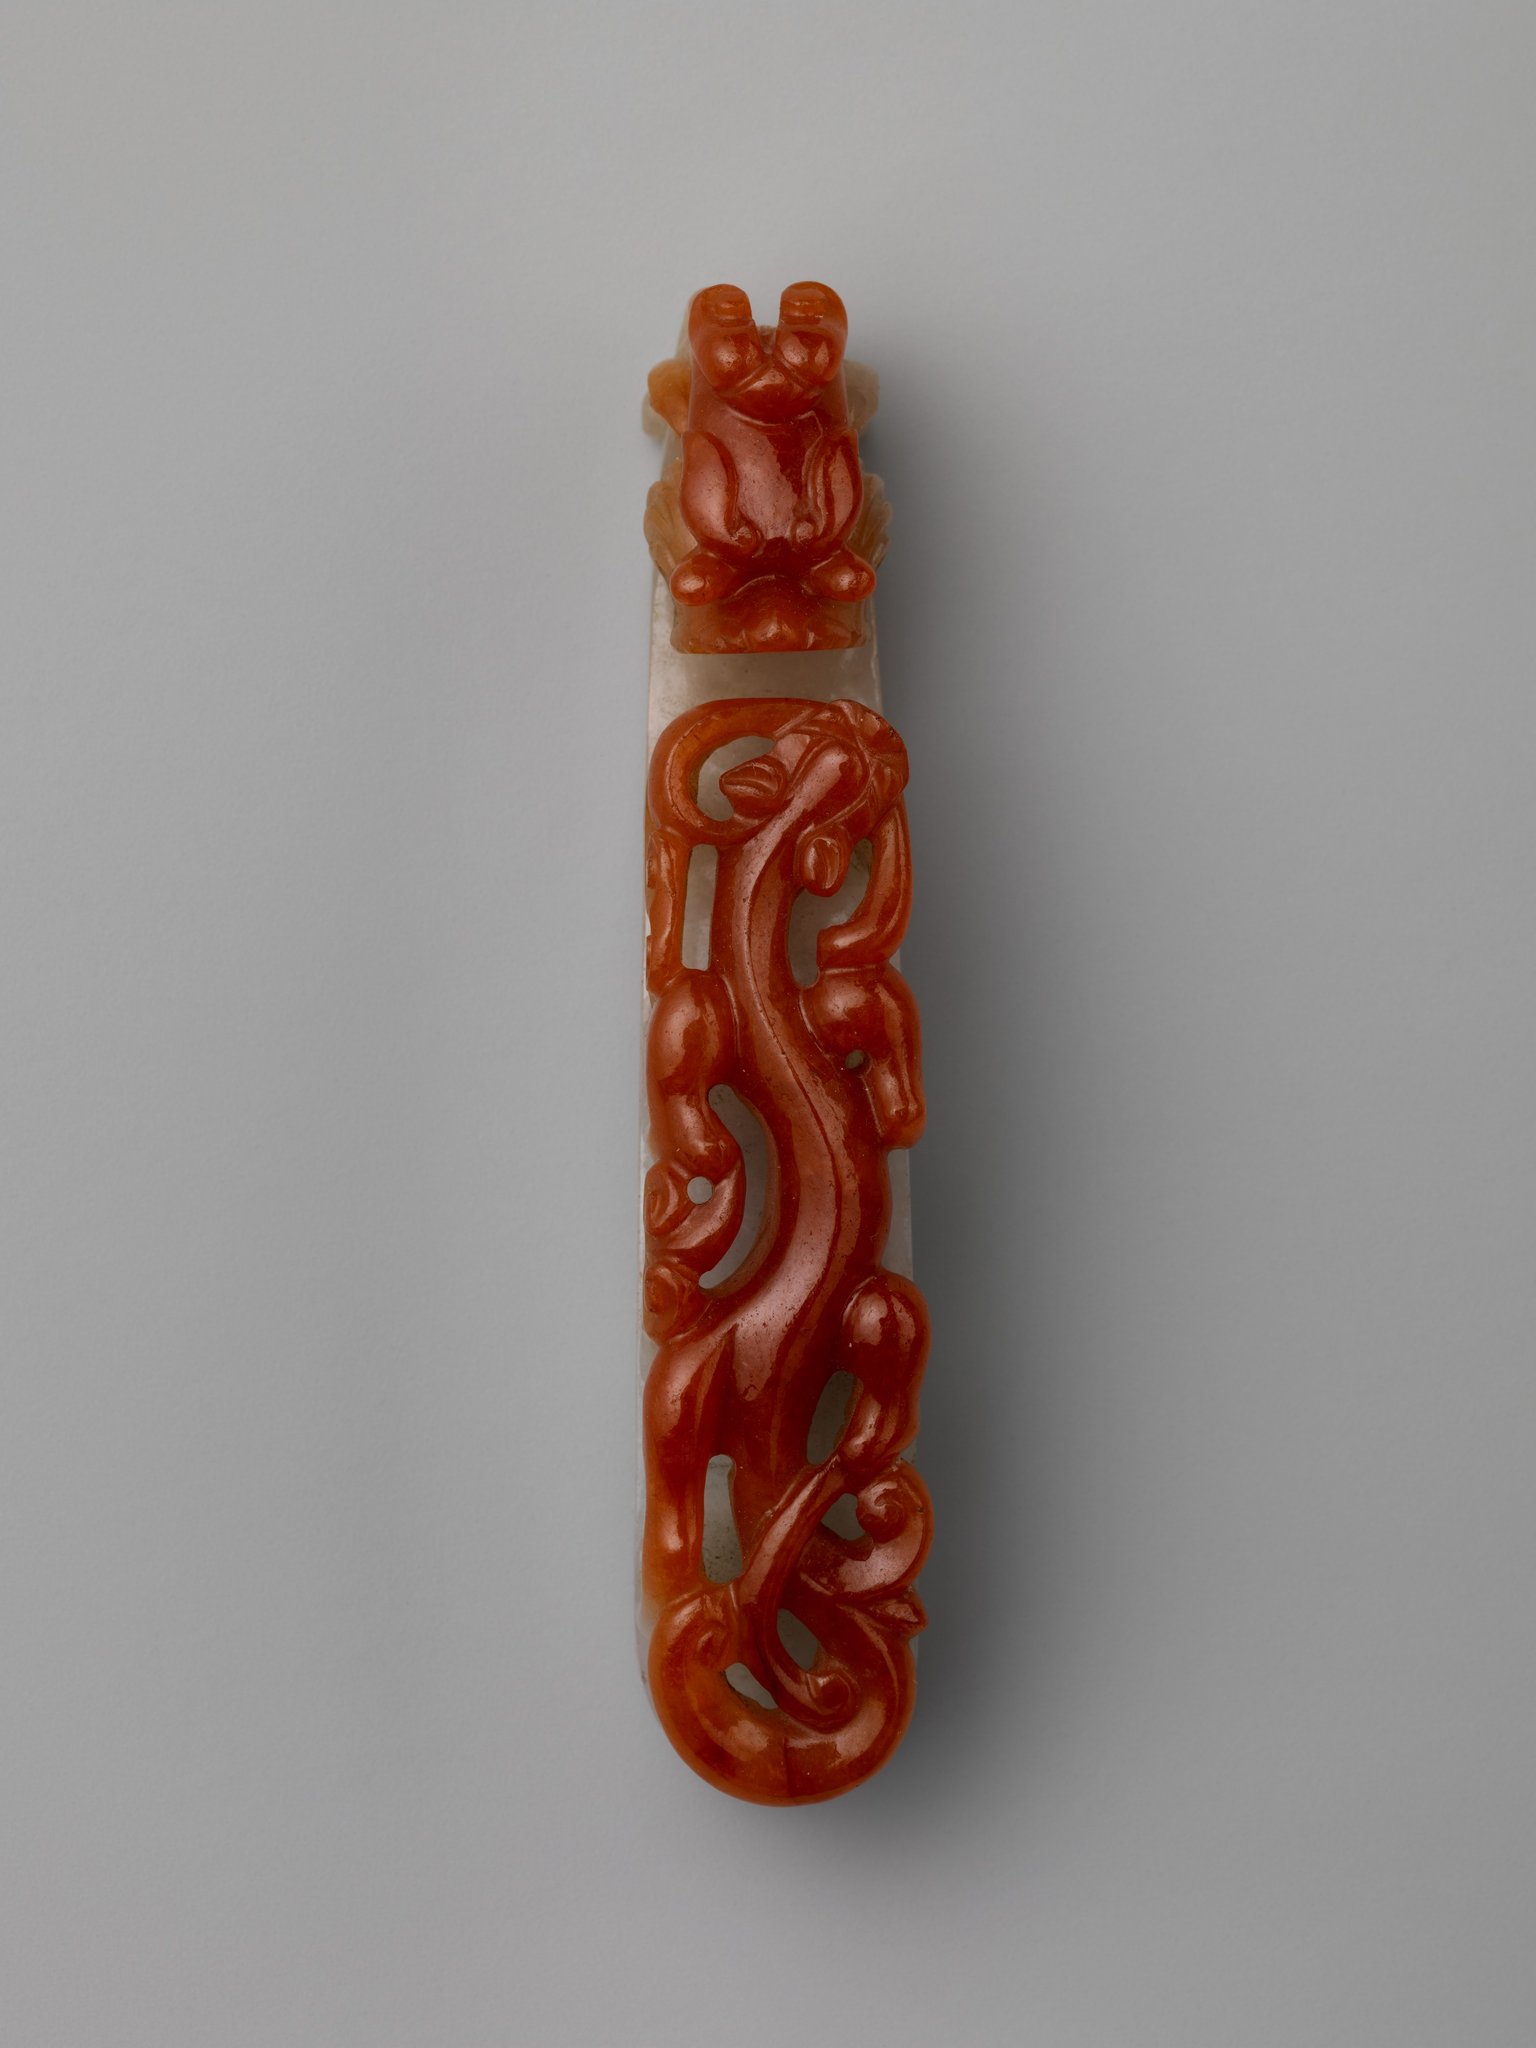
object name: belt hook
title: Belt hook with dragons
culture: chinese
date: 1801-1900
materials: jade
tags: dragons